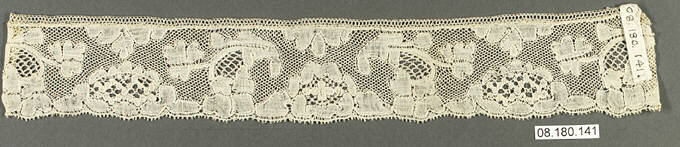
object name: piece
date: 1701-1800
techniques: lace